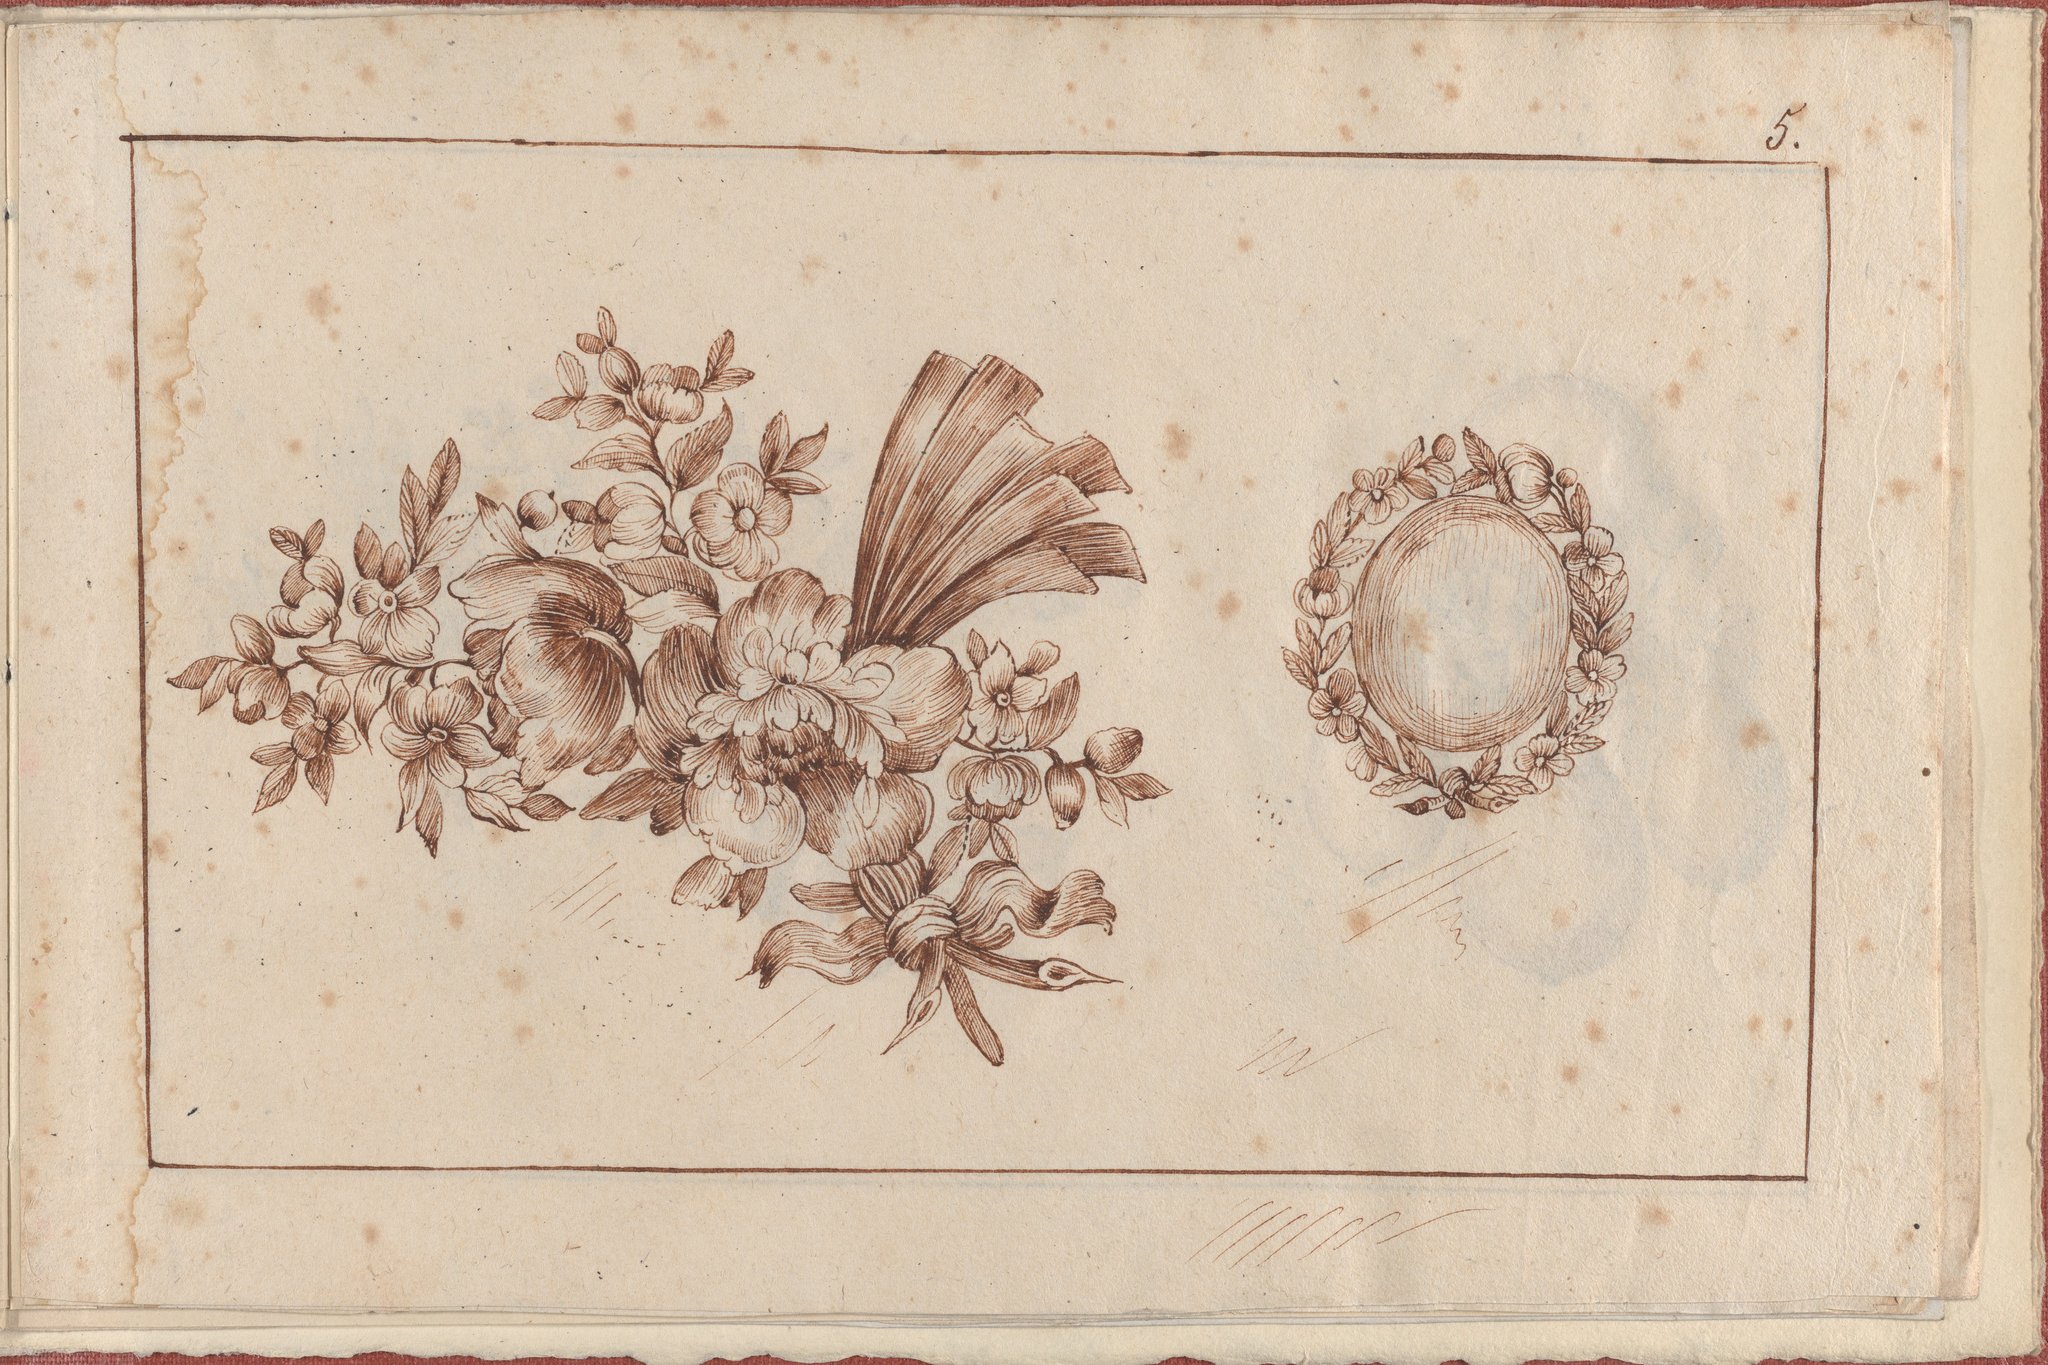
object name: album print ornament architecture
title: Joaillerie: Album of Jewelry Designs, Page 5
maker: anonymous, french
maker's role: artist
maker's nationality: french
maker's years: 1400-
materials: ink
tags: jewelry